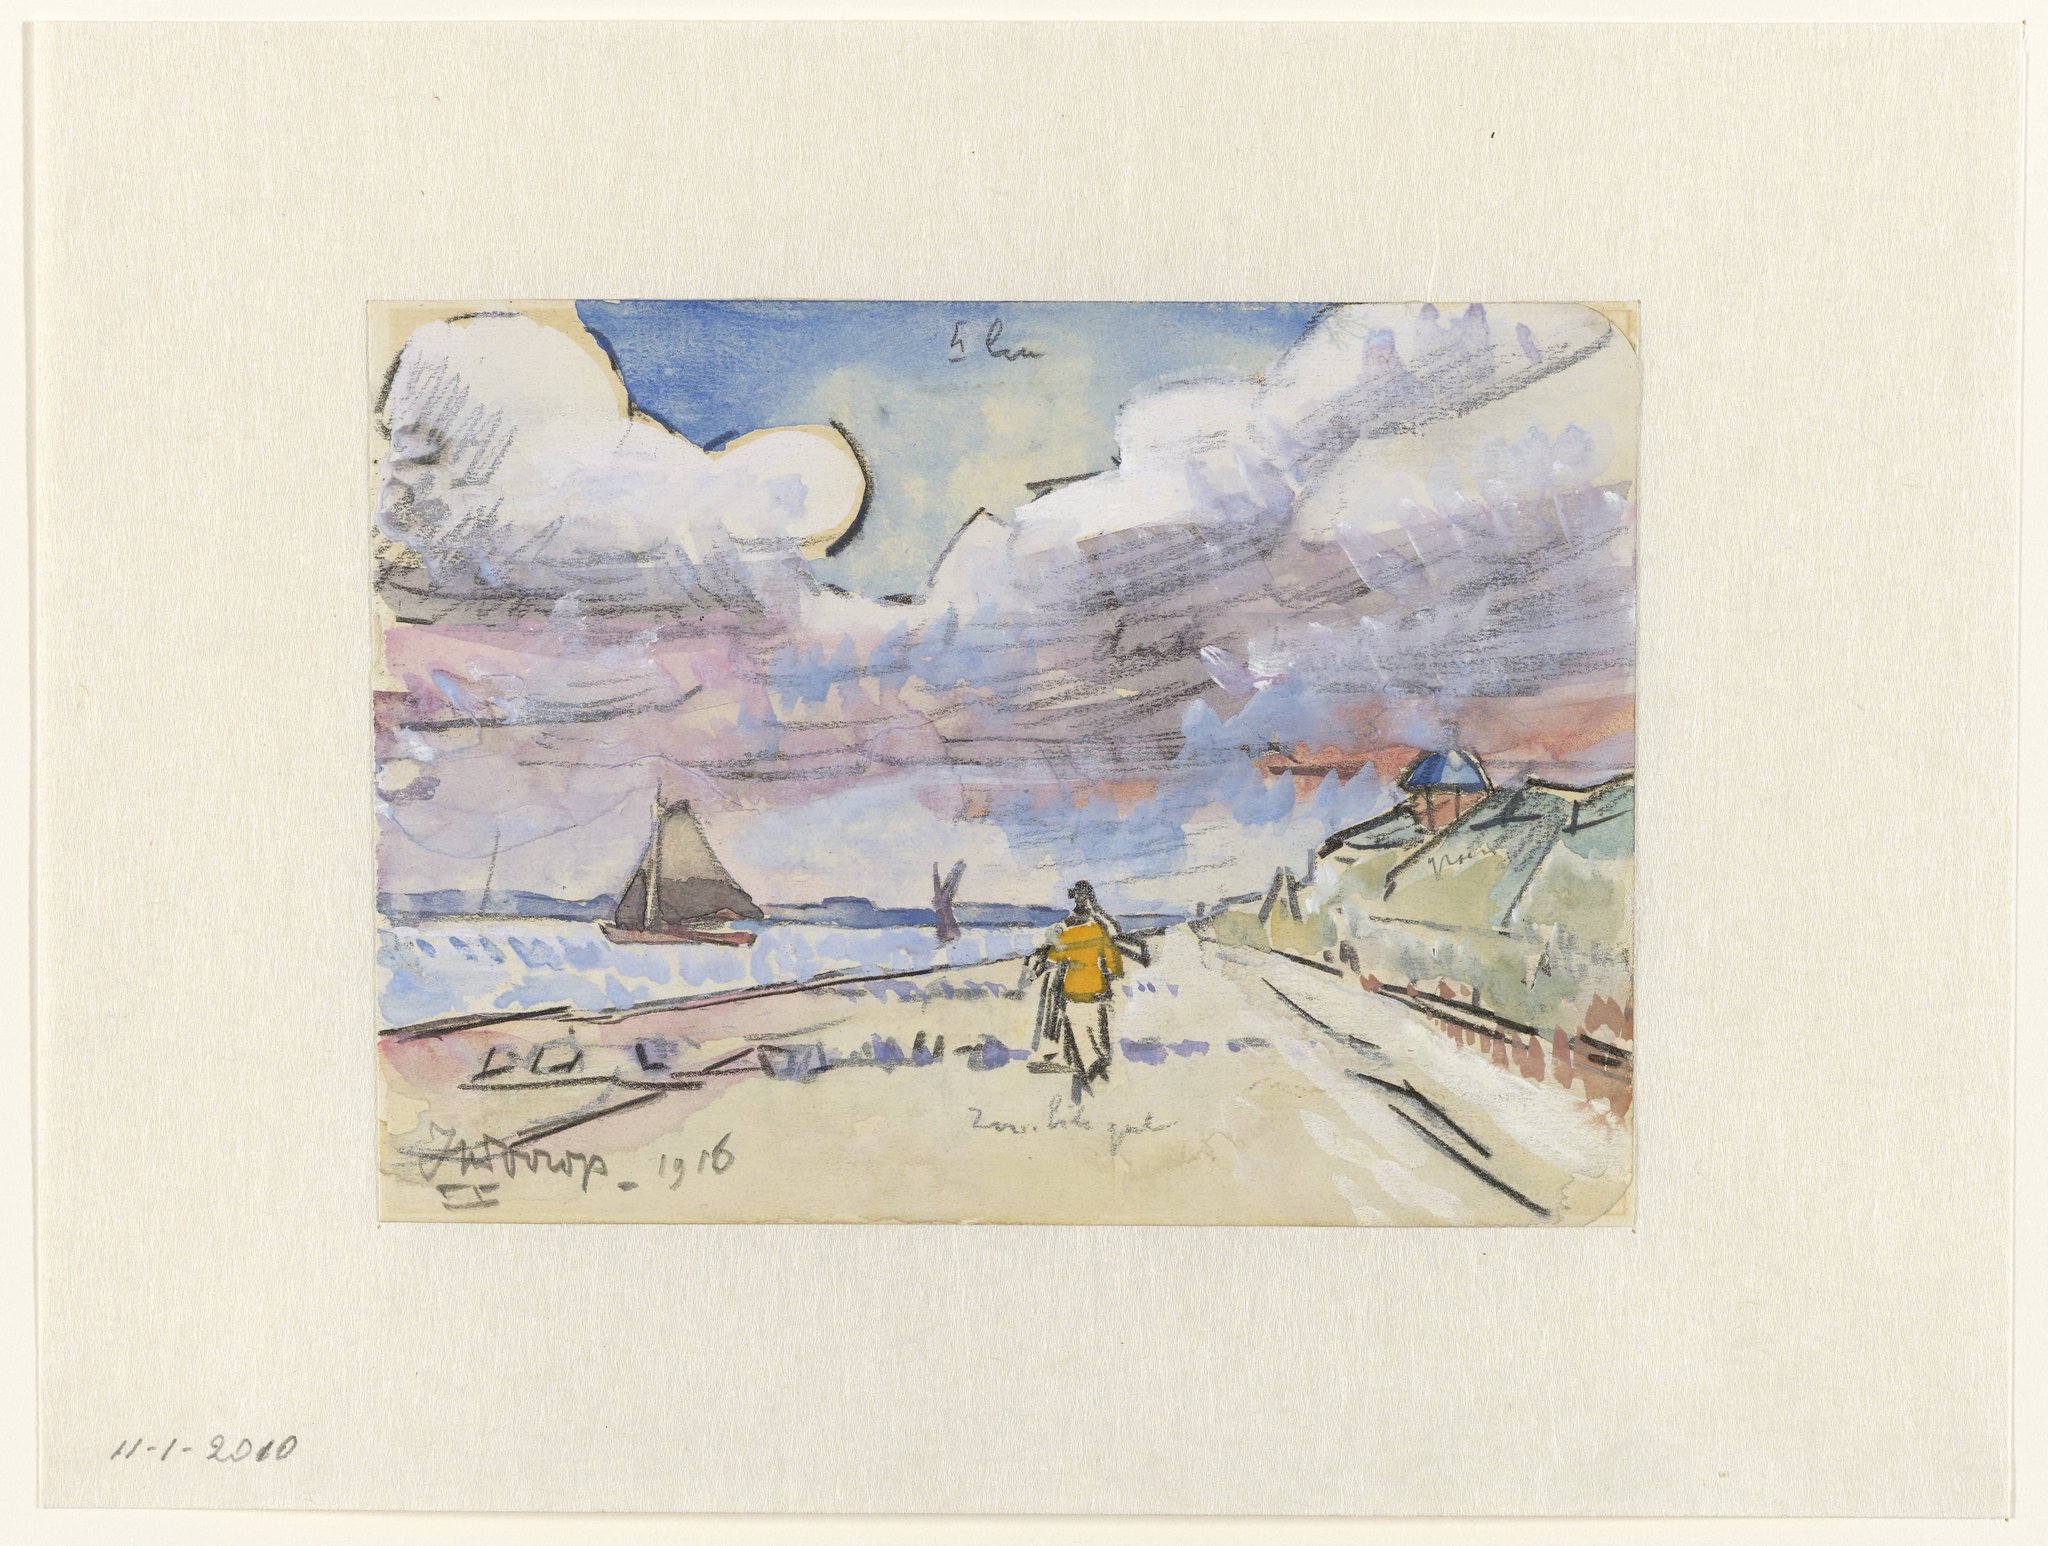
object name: drawing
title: Weg langs kanaal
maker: jan toorop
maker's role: draughtsman, painter, print maker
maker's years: 1858-1928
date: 1916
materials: chalk, paper, watercolor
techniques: brush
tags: canal